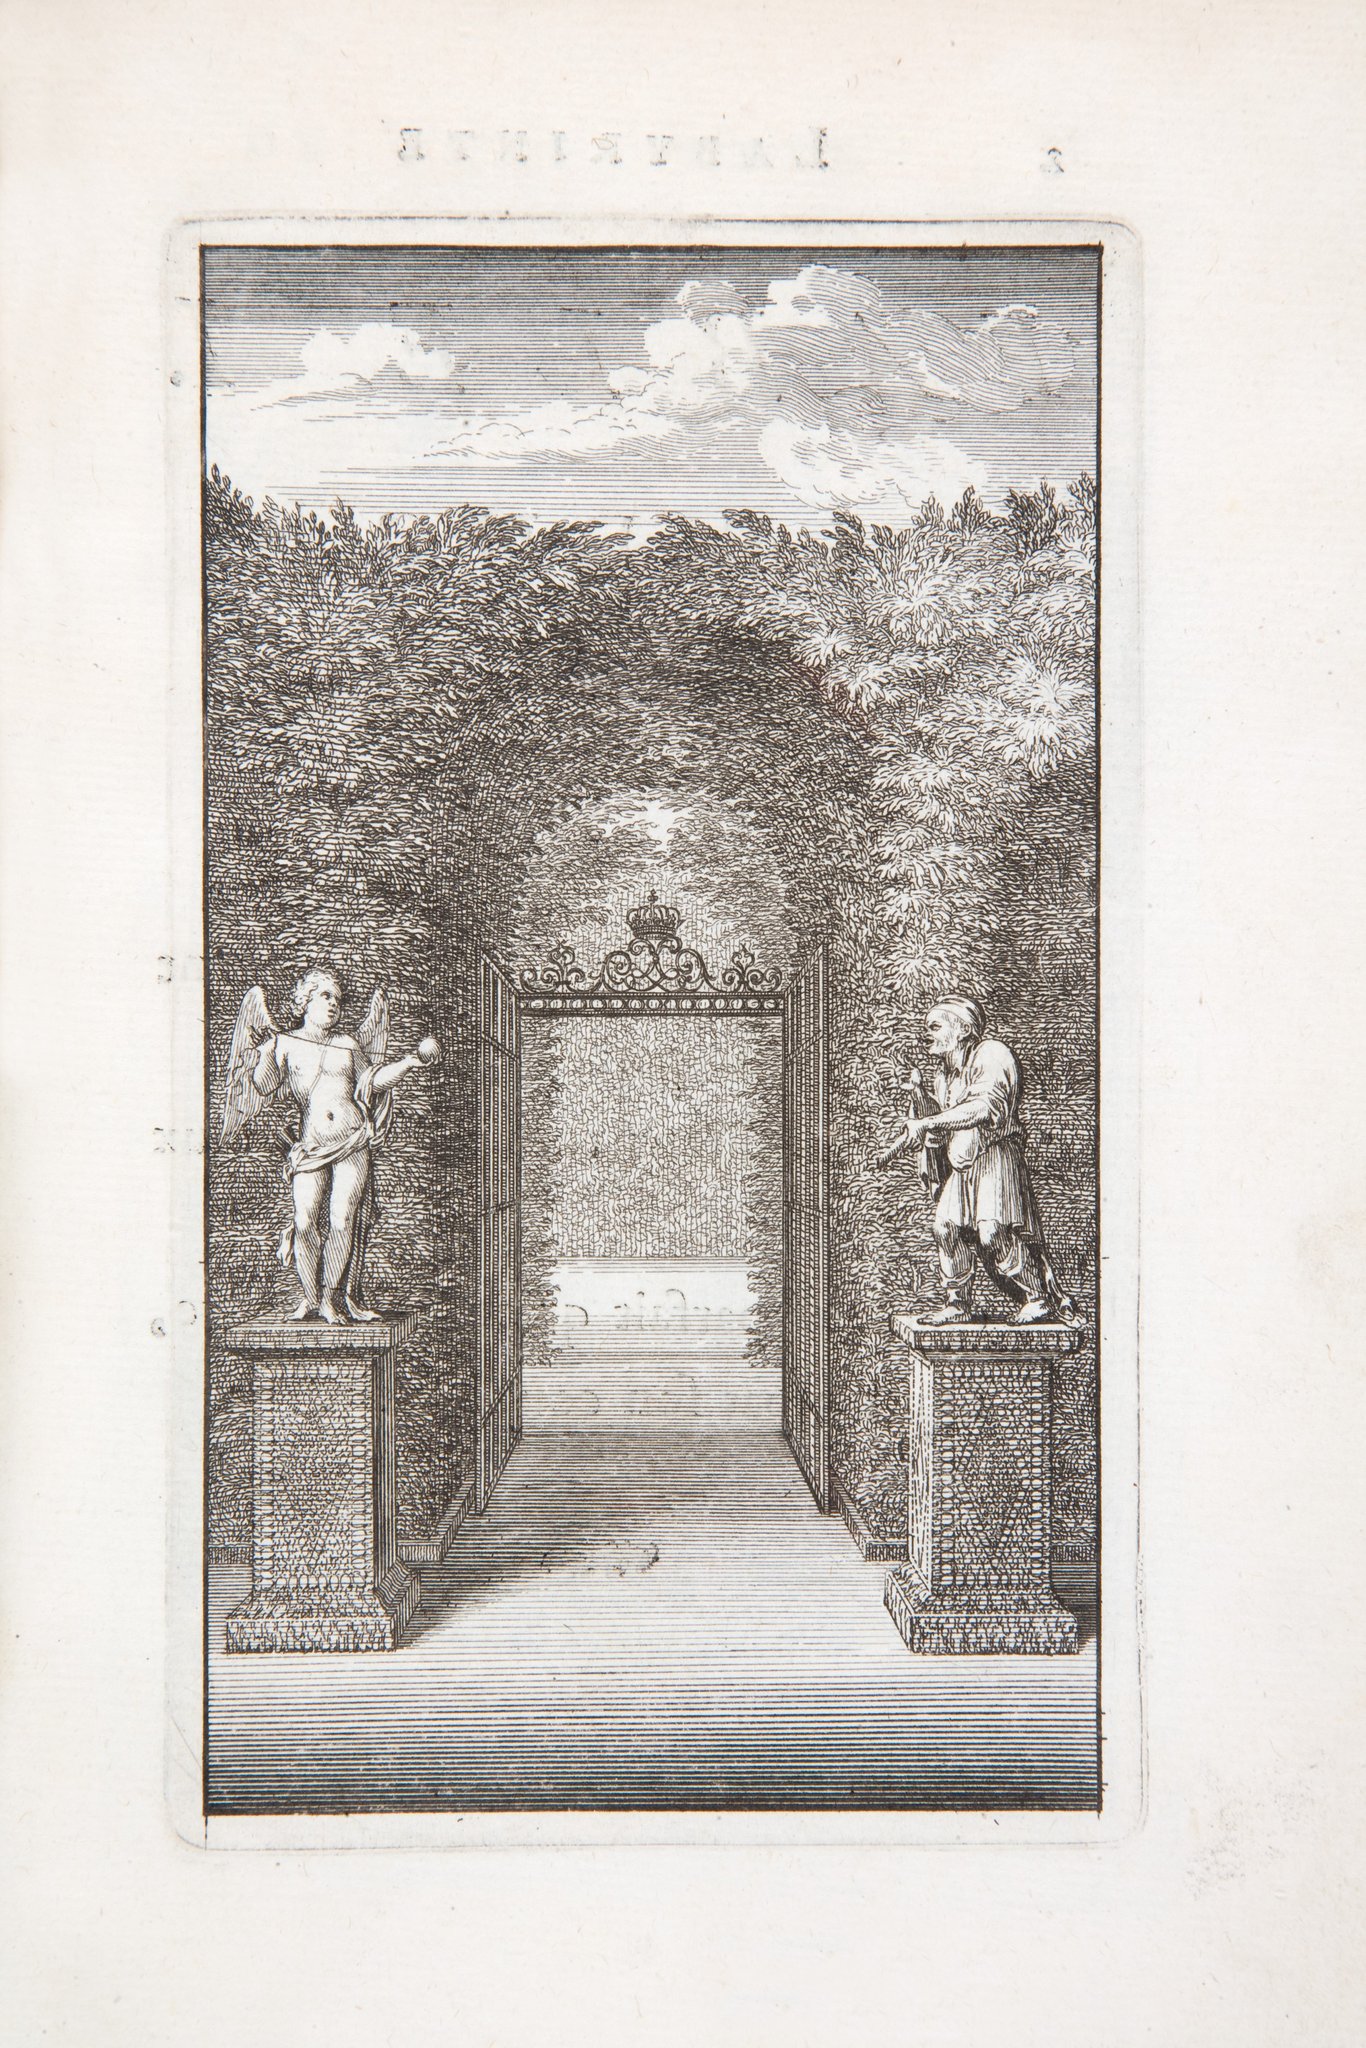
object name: book print ornament architecture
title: Labyrinte de Versailles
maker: isaac de benserade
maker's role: author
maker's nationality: french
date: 1677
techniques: etching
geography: france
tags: sculpture,gates